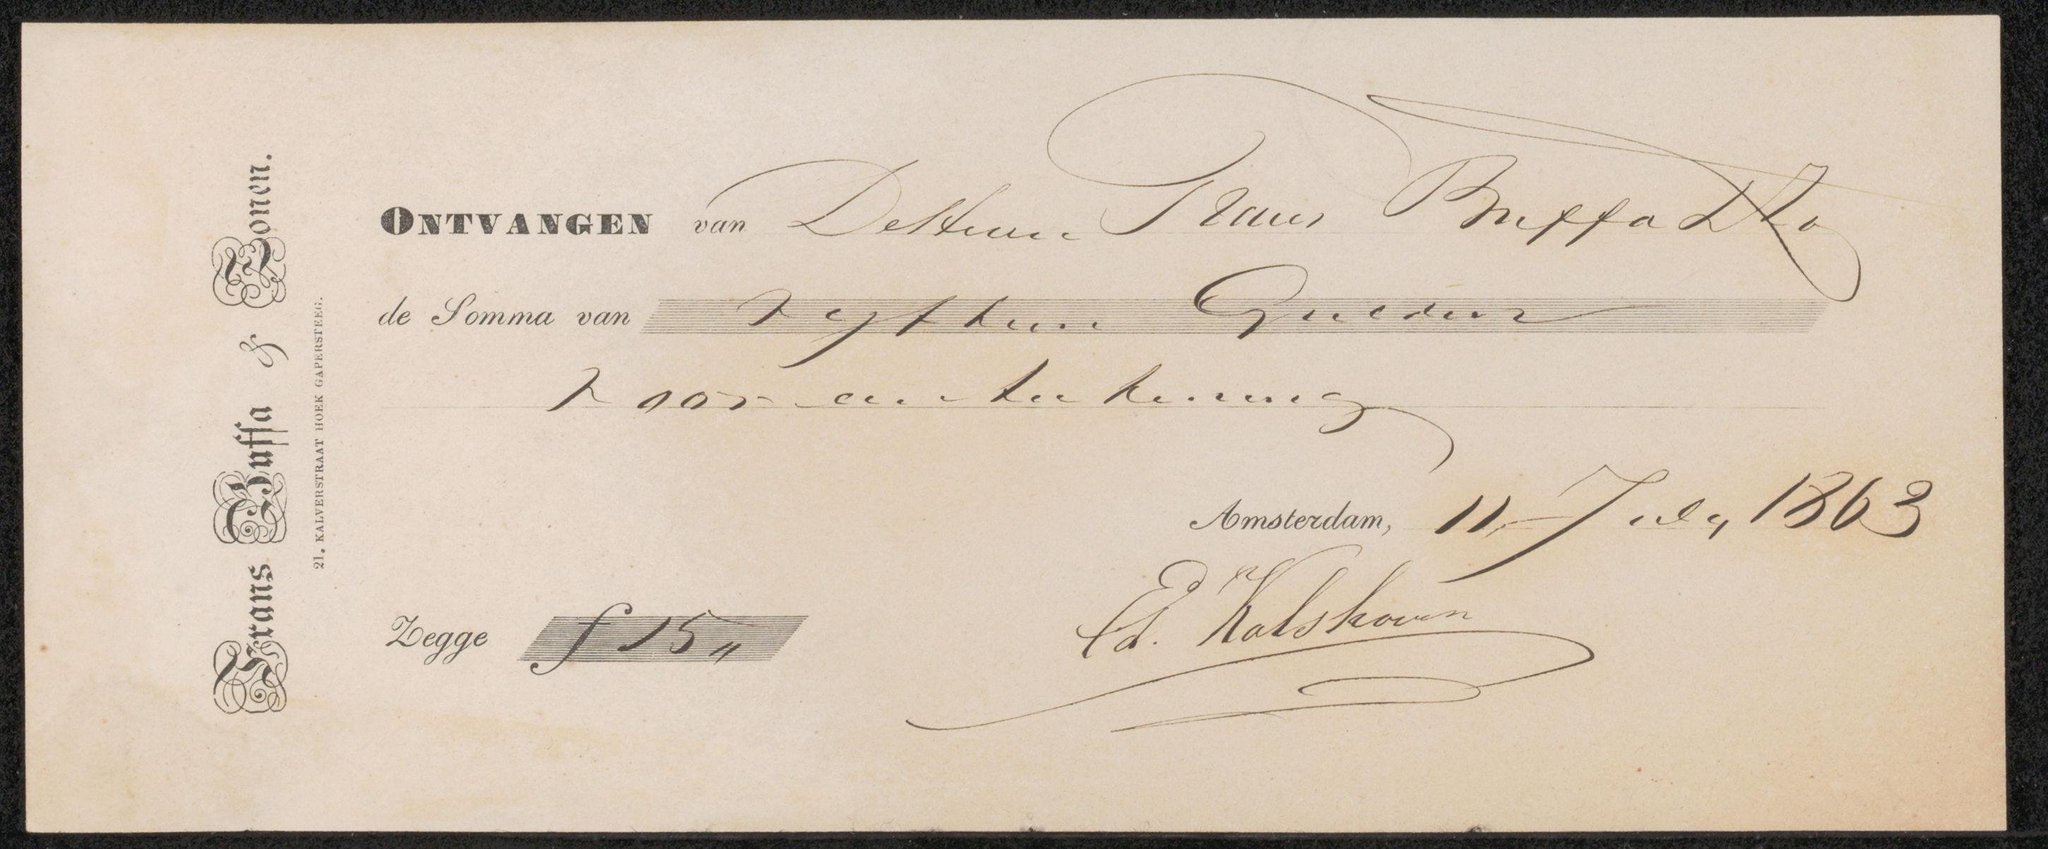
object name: ontvangstbewijs, kwitantie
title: Kwitantie voor Eduard Charles Louis Kalshoven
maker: eduard charles louis kalshoven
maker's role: painter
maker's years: 1836-1866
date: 1863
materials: ink, paper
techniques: pen, printing, writing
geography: amsterdam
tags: drawing, money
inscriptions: collector's mark: Lugt 2233